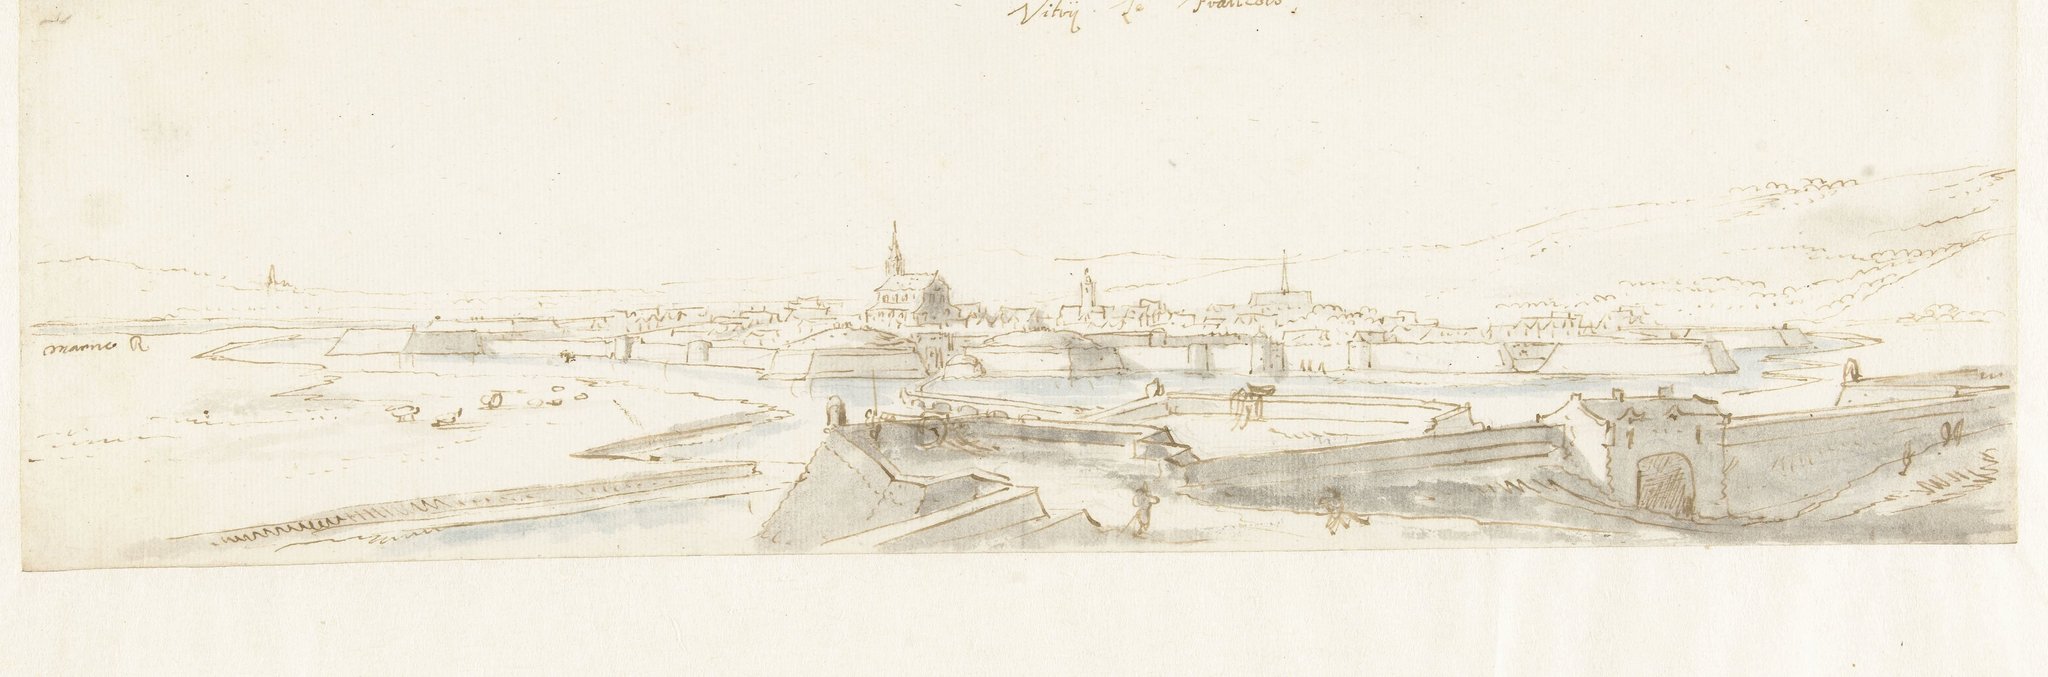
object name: design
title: Gezicht op Vitry le François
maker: jan peeters (1624-1678)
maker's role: draughtsman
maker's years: 1624-1680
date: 1654-1656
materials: chalk, ink, paper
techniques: brush, pen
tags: prospect of city, town panorama, silhouette of city, france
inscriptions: inscription: ‘Vitrij le Francois’